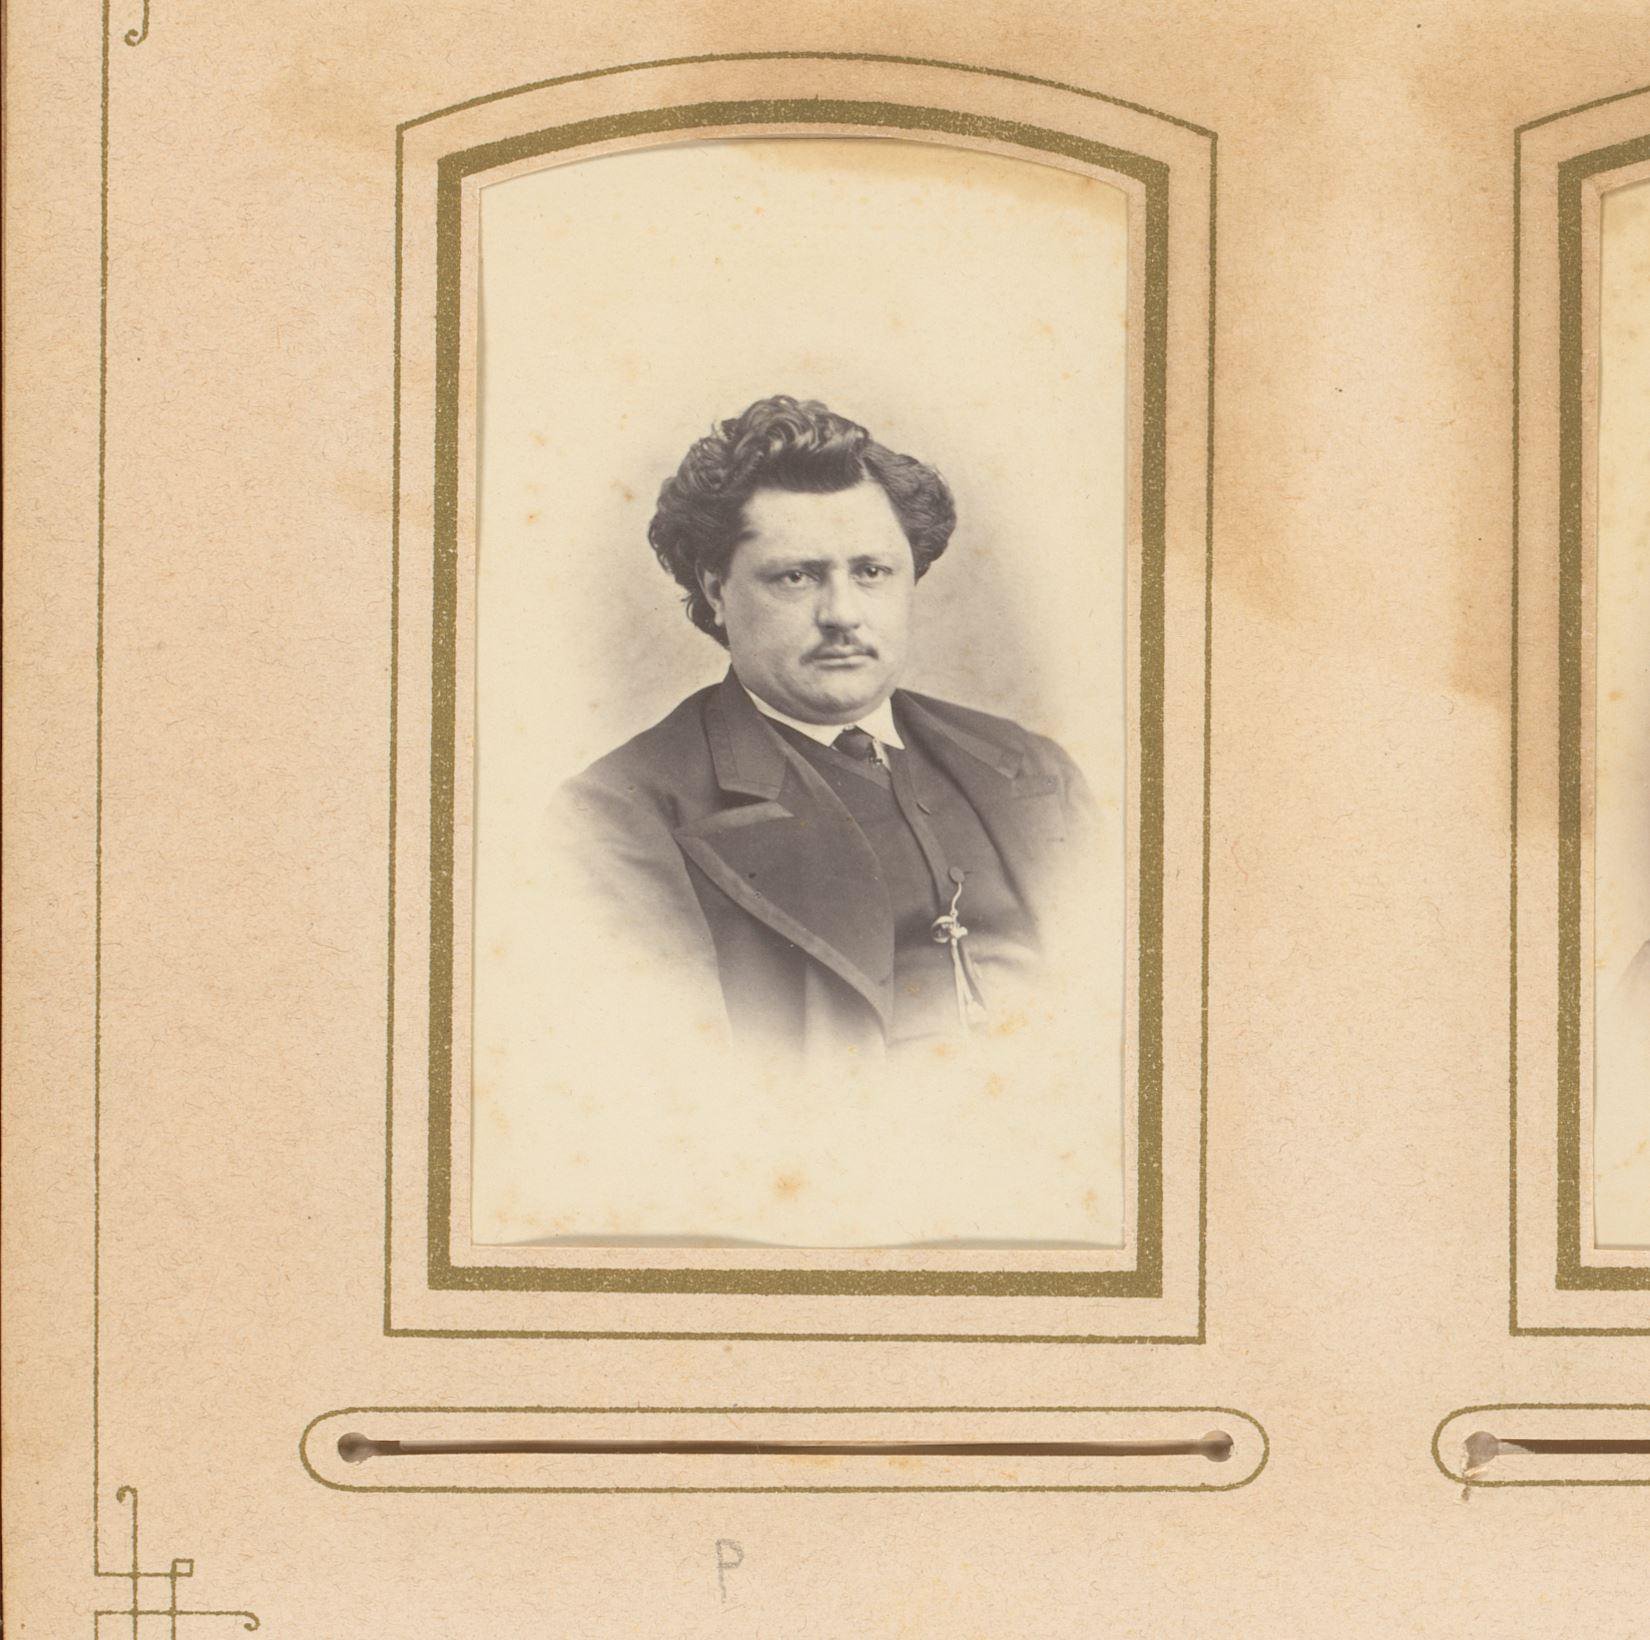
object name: photograph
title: Portret van een man met snor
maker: antonius godefridus schull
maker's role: fotograaf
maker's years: 1819-1896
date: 1804-1869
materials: cardboard, photographic support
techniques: albumen print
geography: den bosch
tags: moustache, historical persons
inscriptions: date: ‘April 1869’, inscription: ‘PHOTOGRAPHIE/ A. G. SCHULL/ Kerkstraat/ 'S HERTOGENBOSCH.’